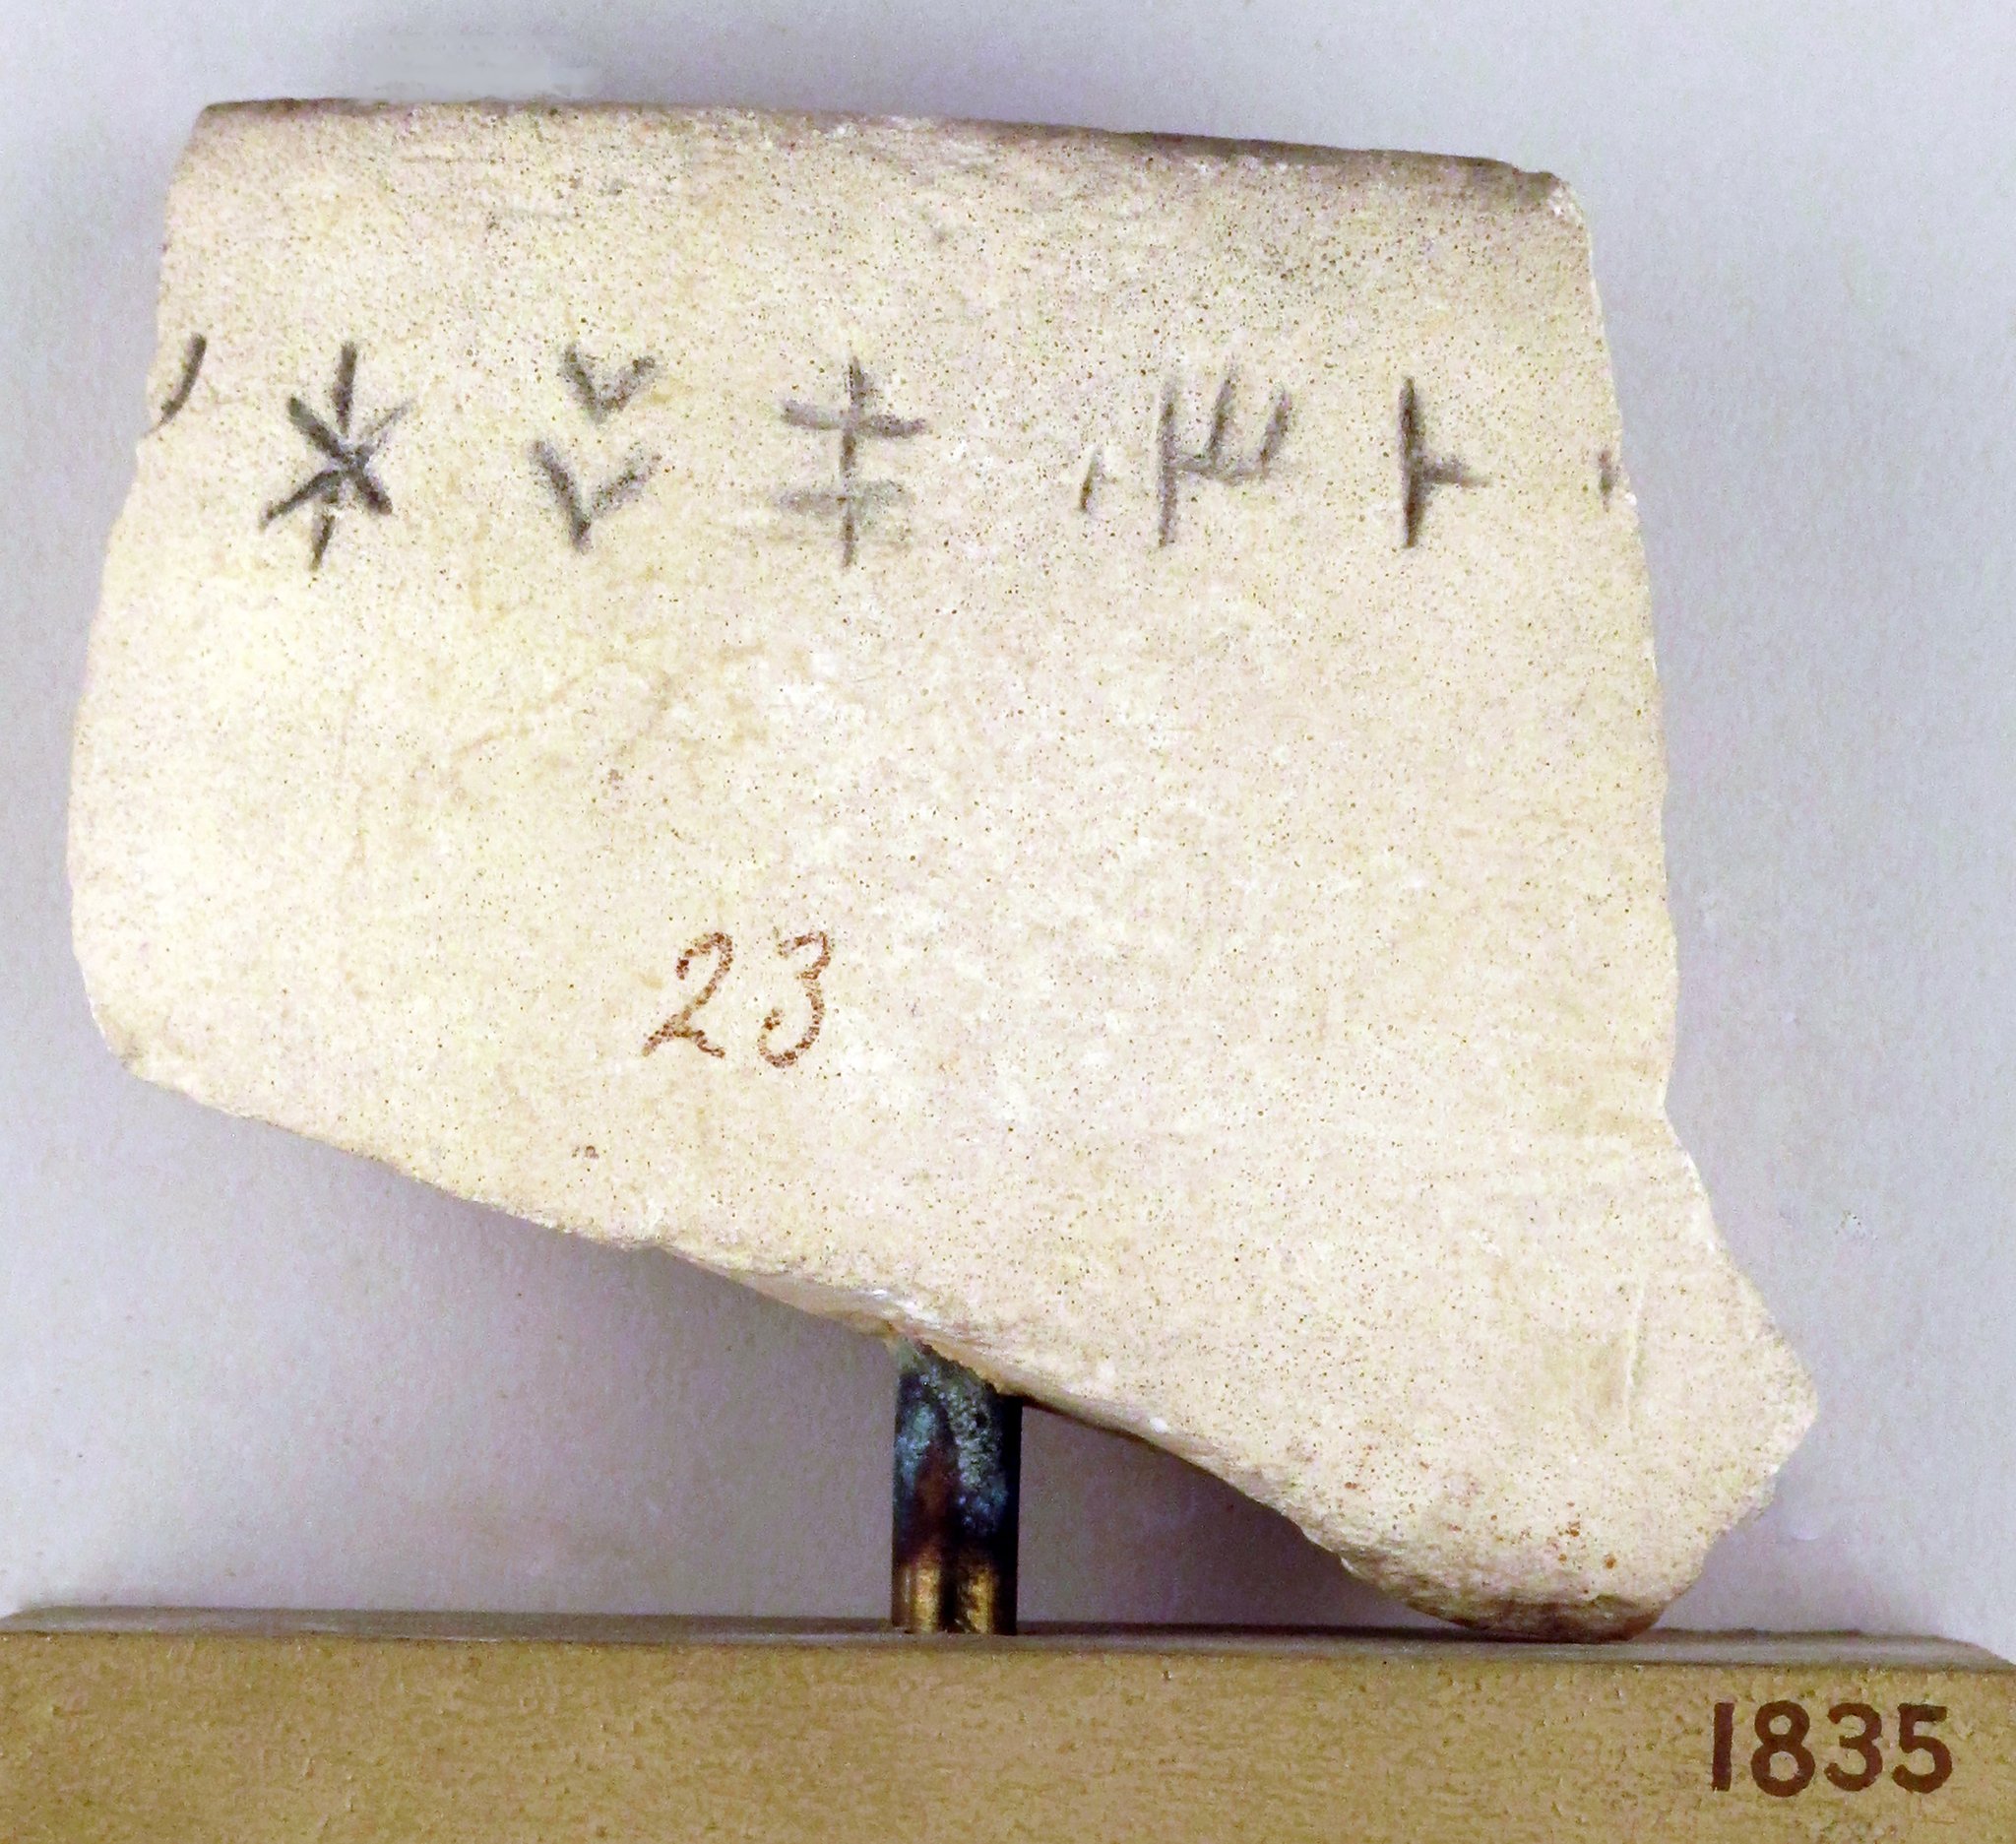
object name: box, inscribed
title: Limestone inscribed box fragment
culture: cypriot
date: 3900 BCE-100 CE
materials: stone